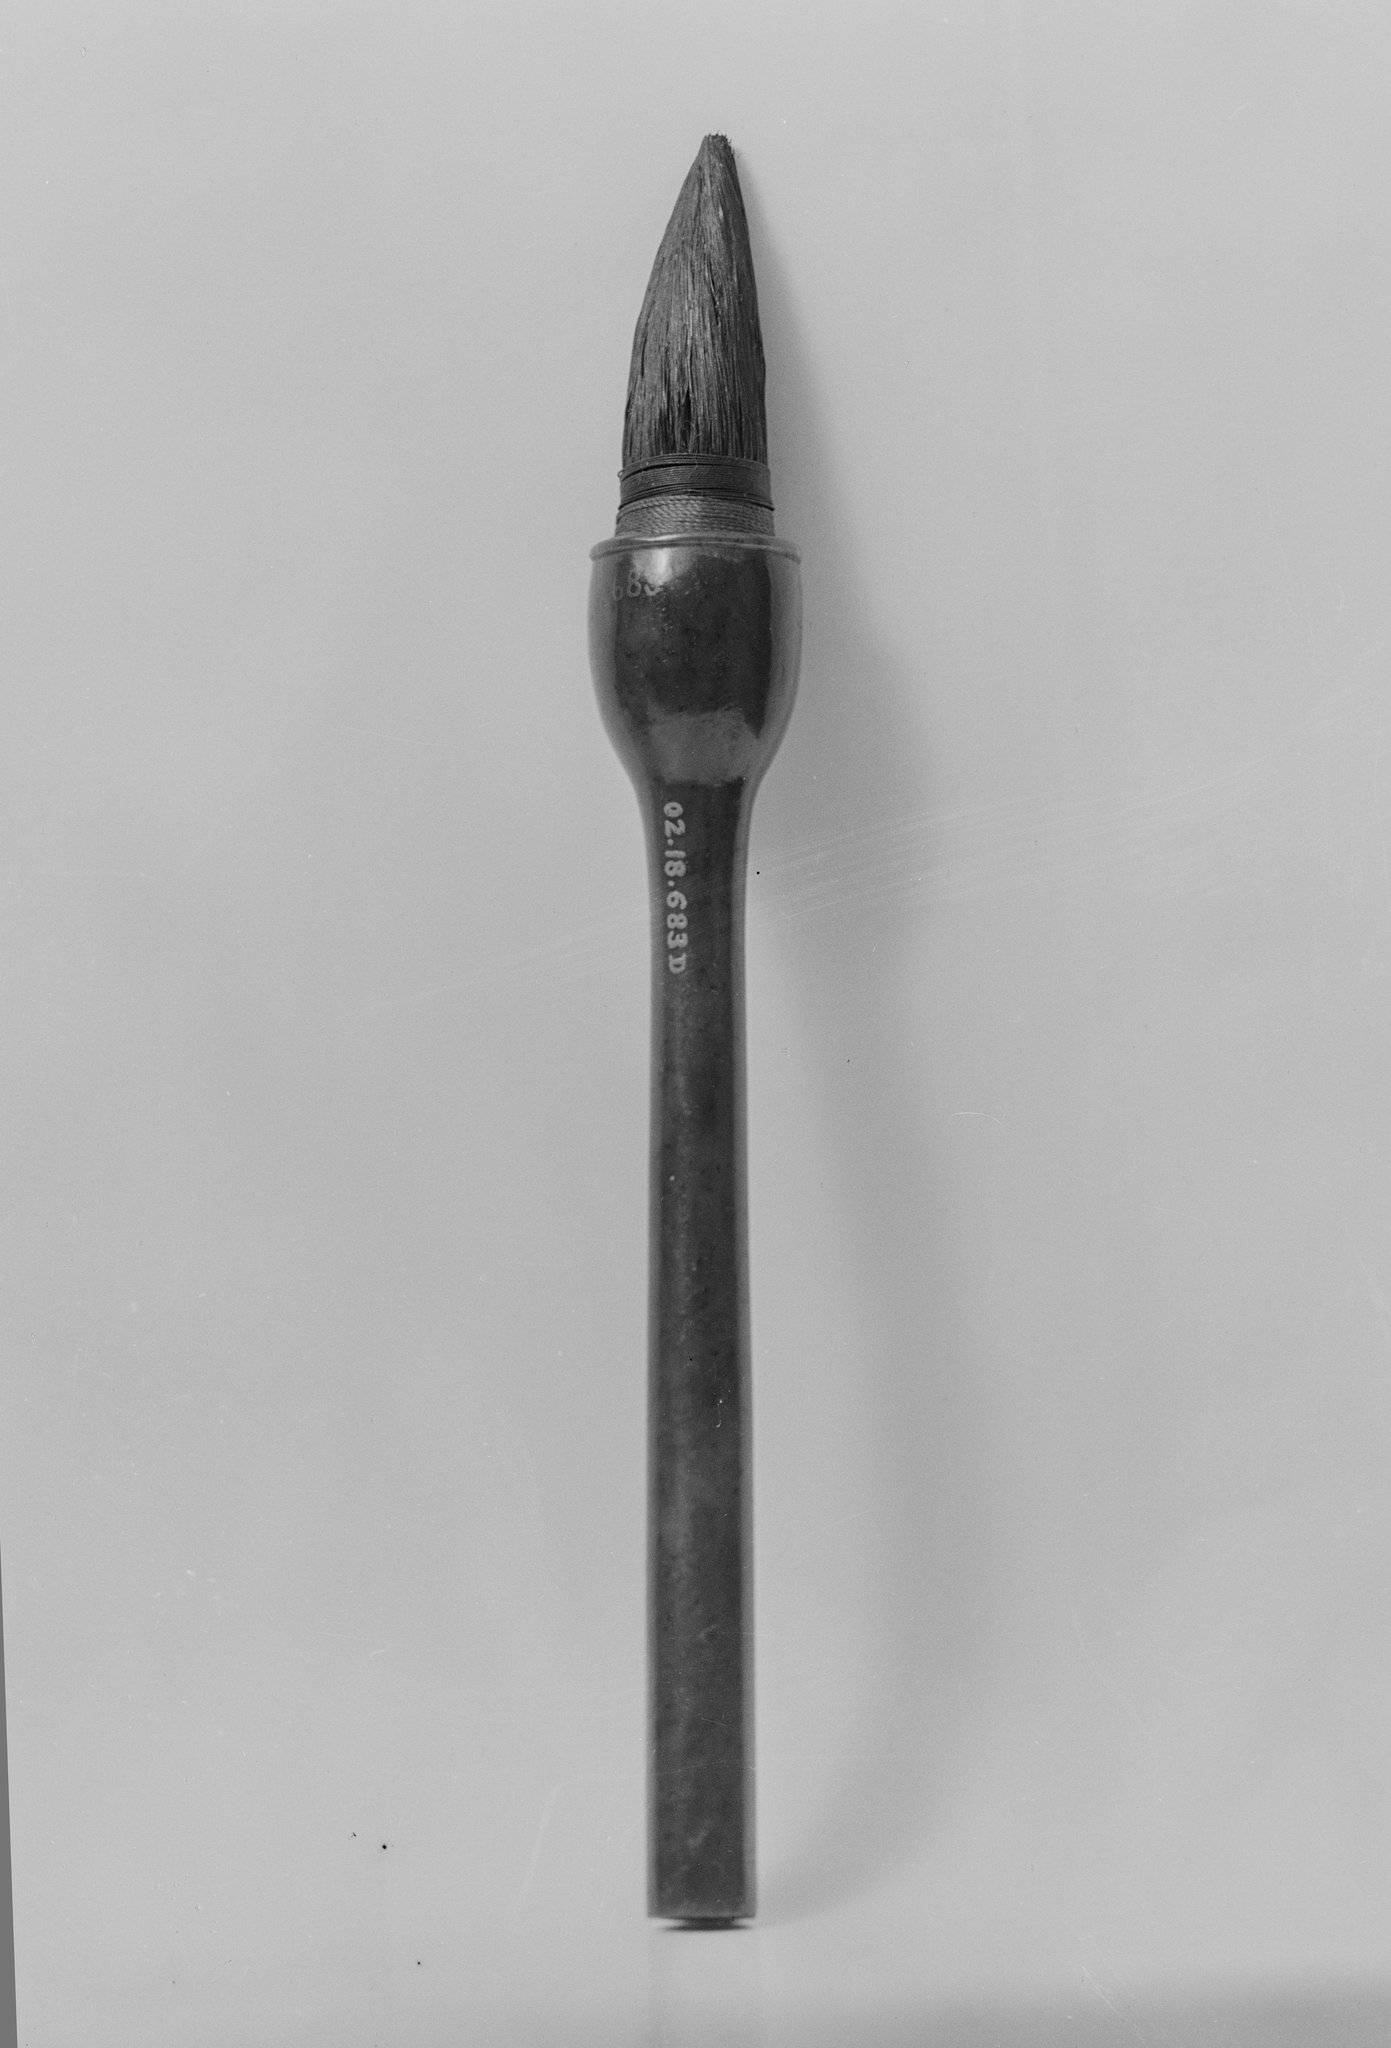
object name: brush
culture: chinese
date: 1736-1795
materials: jade